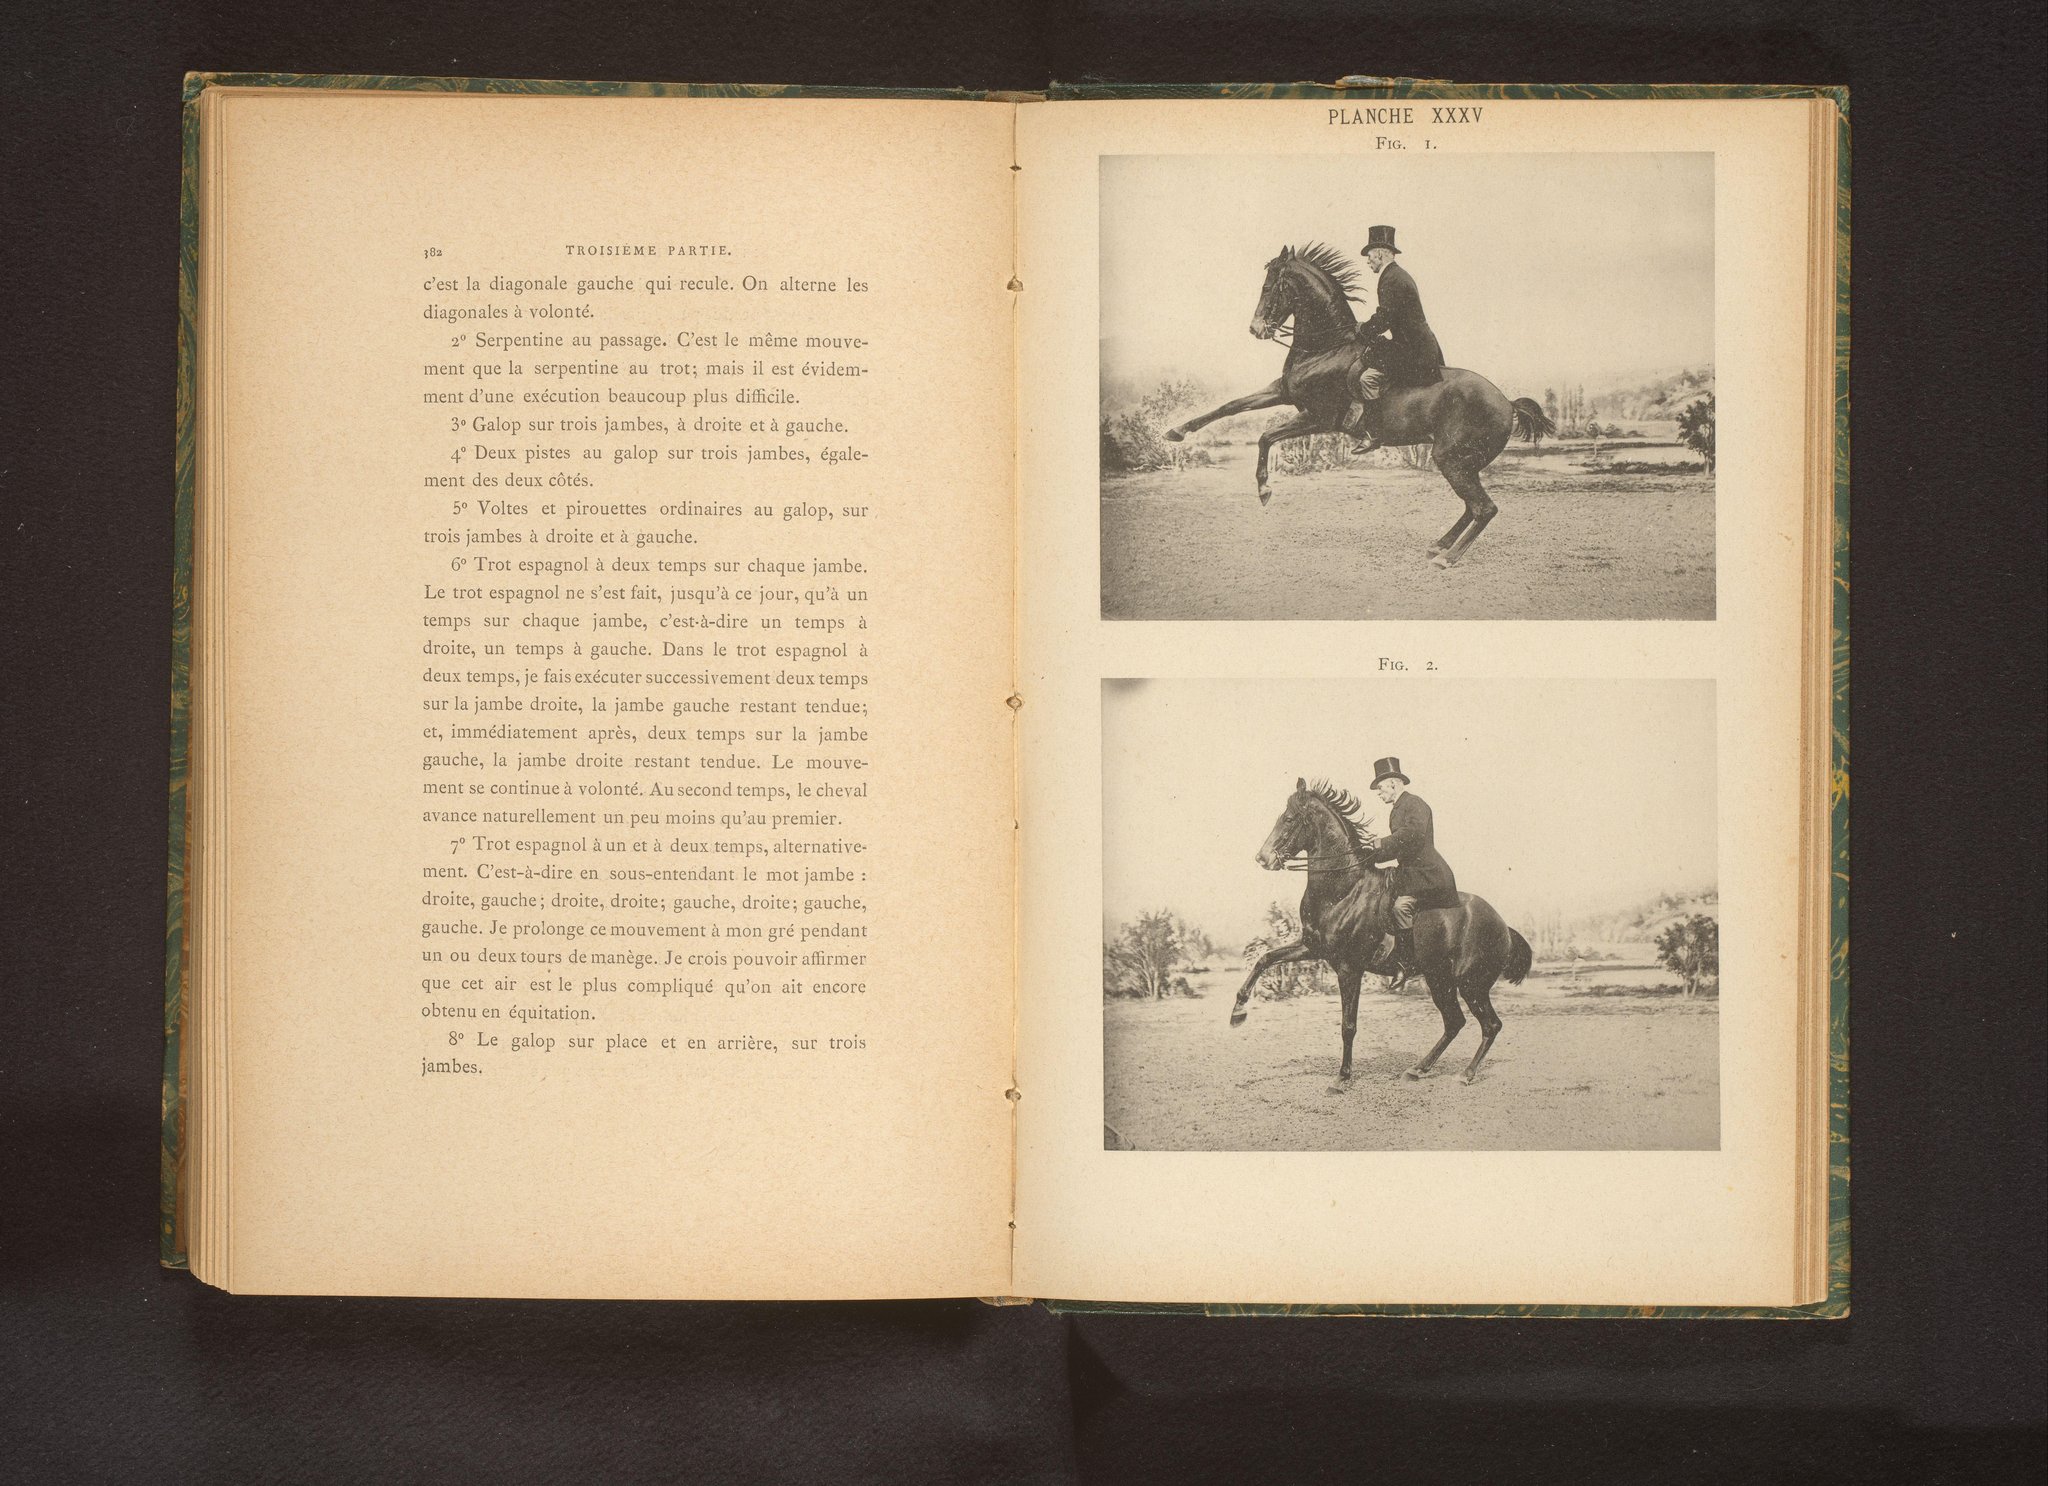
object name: photomechanical print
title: Twee mannen op paarden in beweging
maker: jean delton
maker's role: fotograaf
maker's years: 1850-1901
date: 1882-1892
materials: paper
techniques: photograph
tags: riding a horse, ass, or mule; rider, horseman, head-gear: top hat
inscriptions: number: ‘Planche XXXV Fig. 1. Fig. 2.’